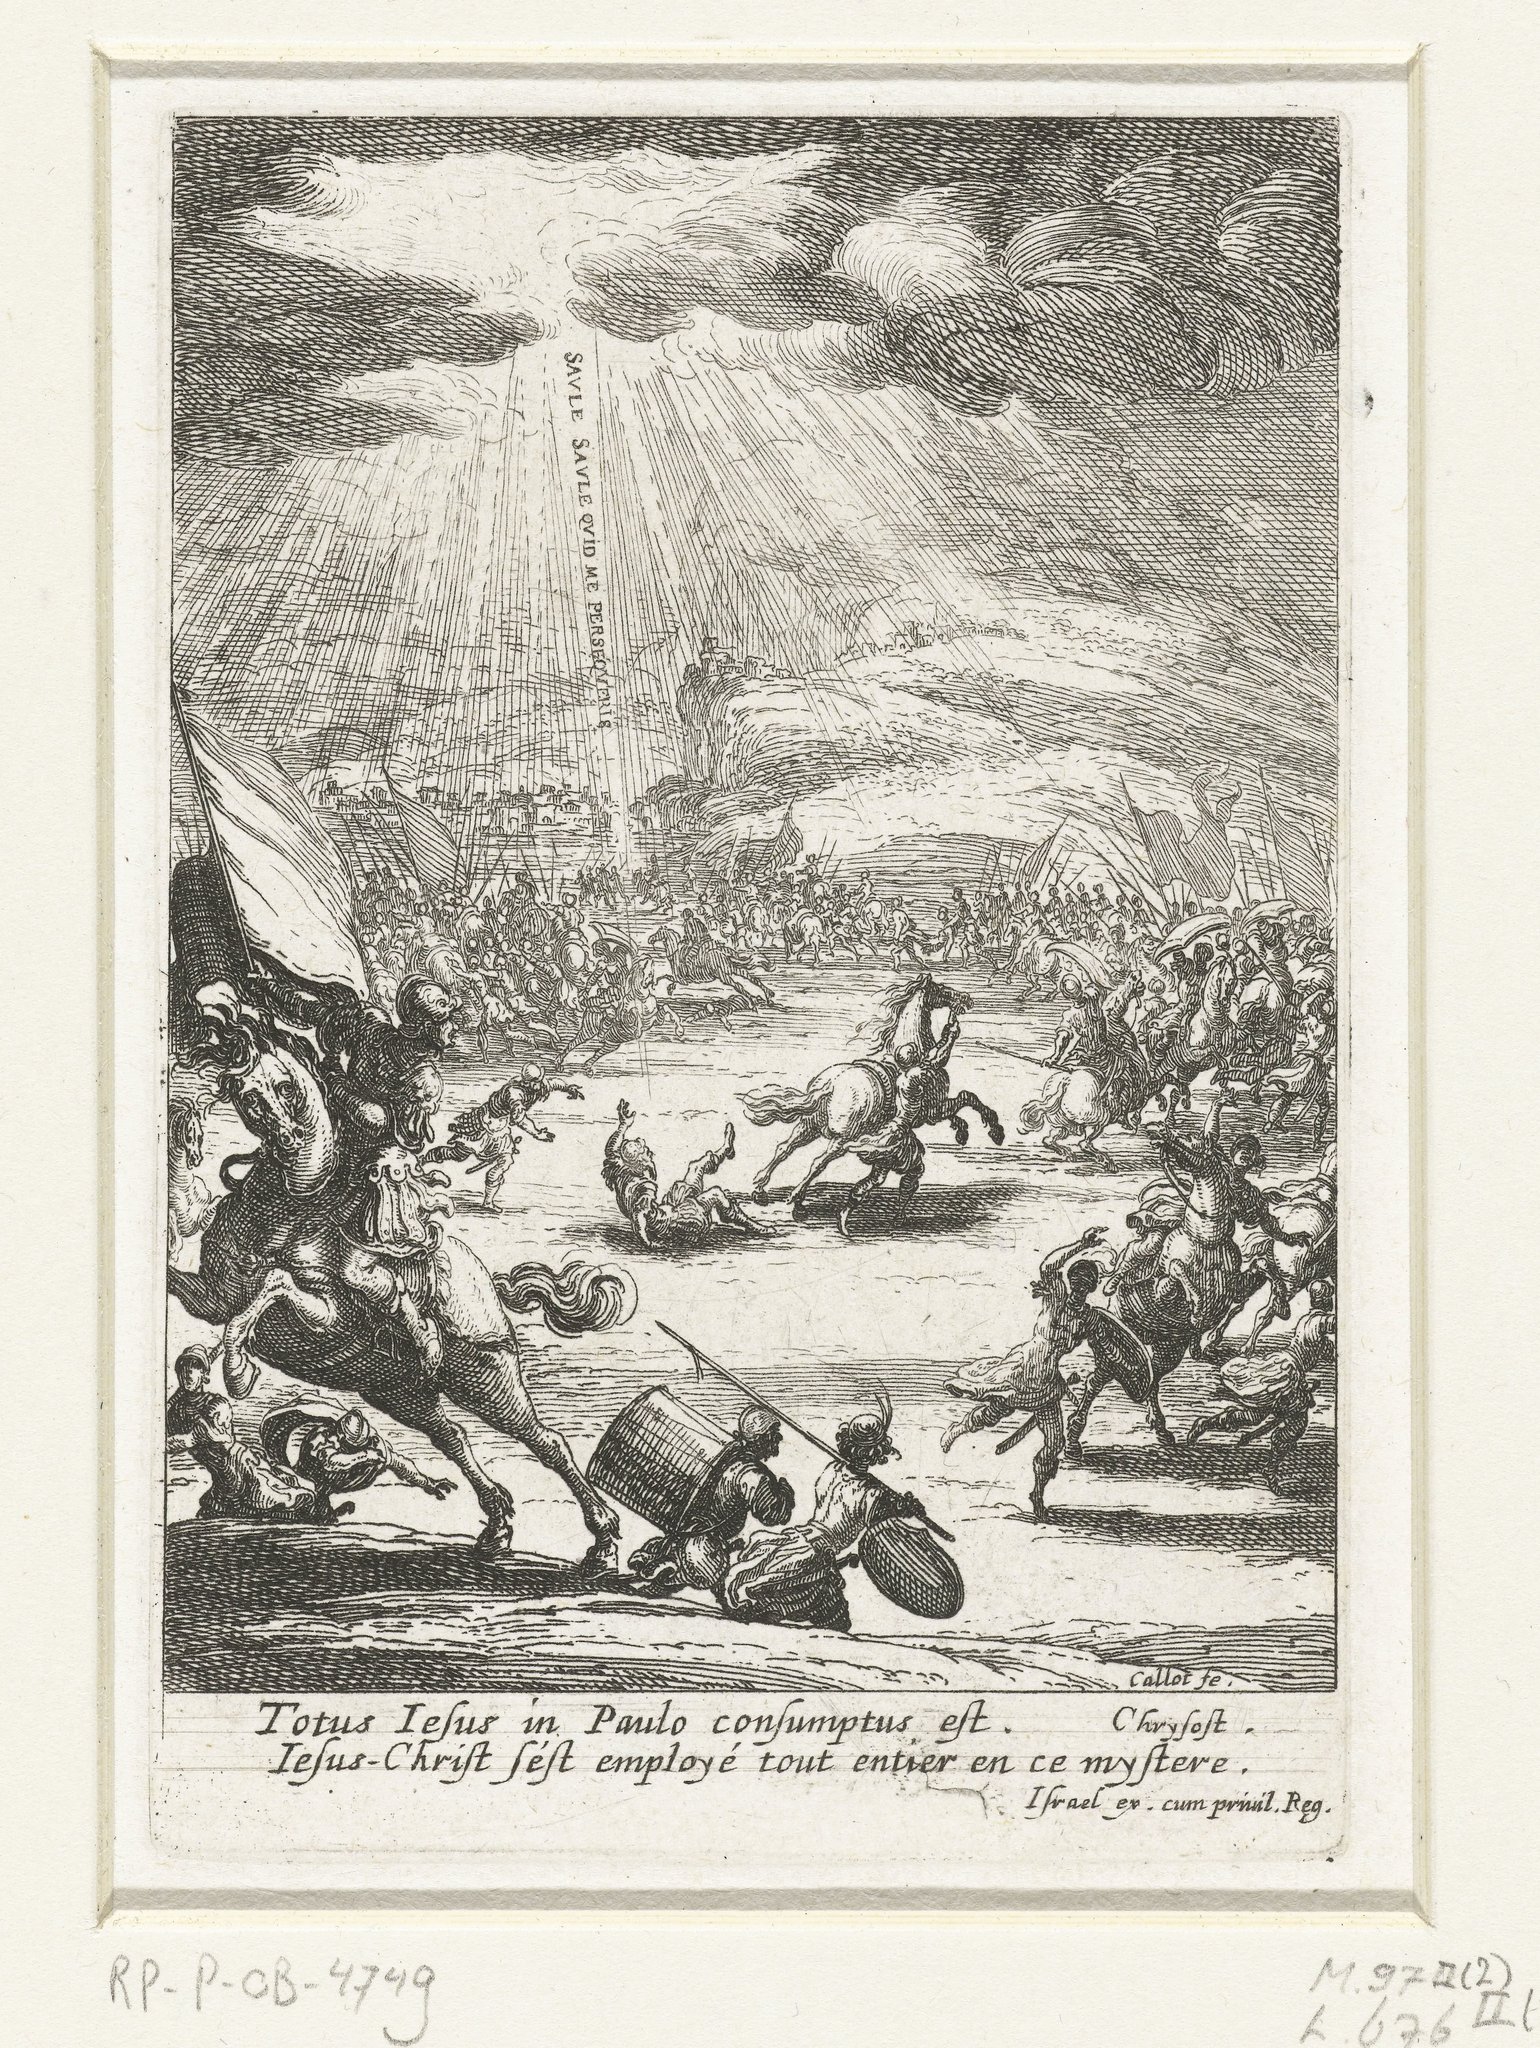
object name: print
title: Bekering van Paulus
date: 1621-1635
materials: paper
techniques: etching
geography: paris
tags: on the way to damascus christ appears to saul, who falls from his horse and is blinded by the light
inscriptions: collector's mark: Lugt 240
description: Te midden van een menigte soldaten, geschrokken van een groot licht en een stem uit de hemel, ligt Paulus op de grond. Een man komt hem te hulp gesneld, een ander houdt zijn paard in bedwang. Op de voorgrond links een ruiter met vaandel. Onder de voorstelling een onderschrift in Latijn.